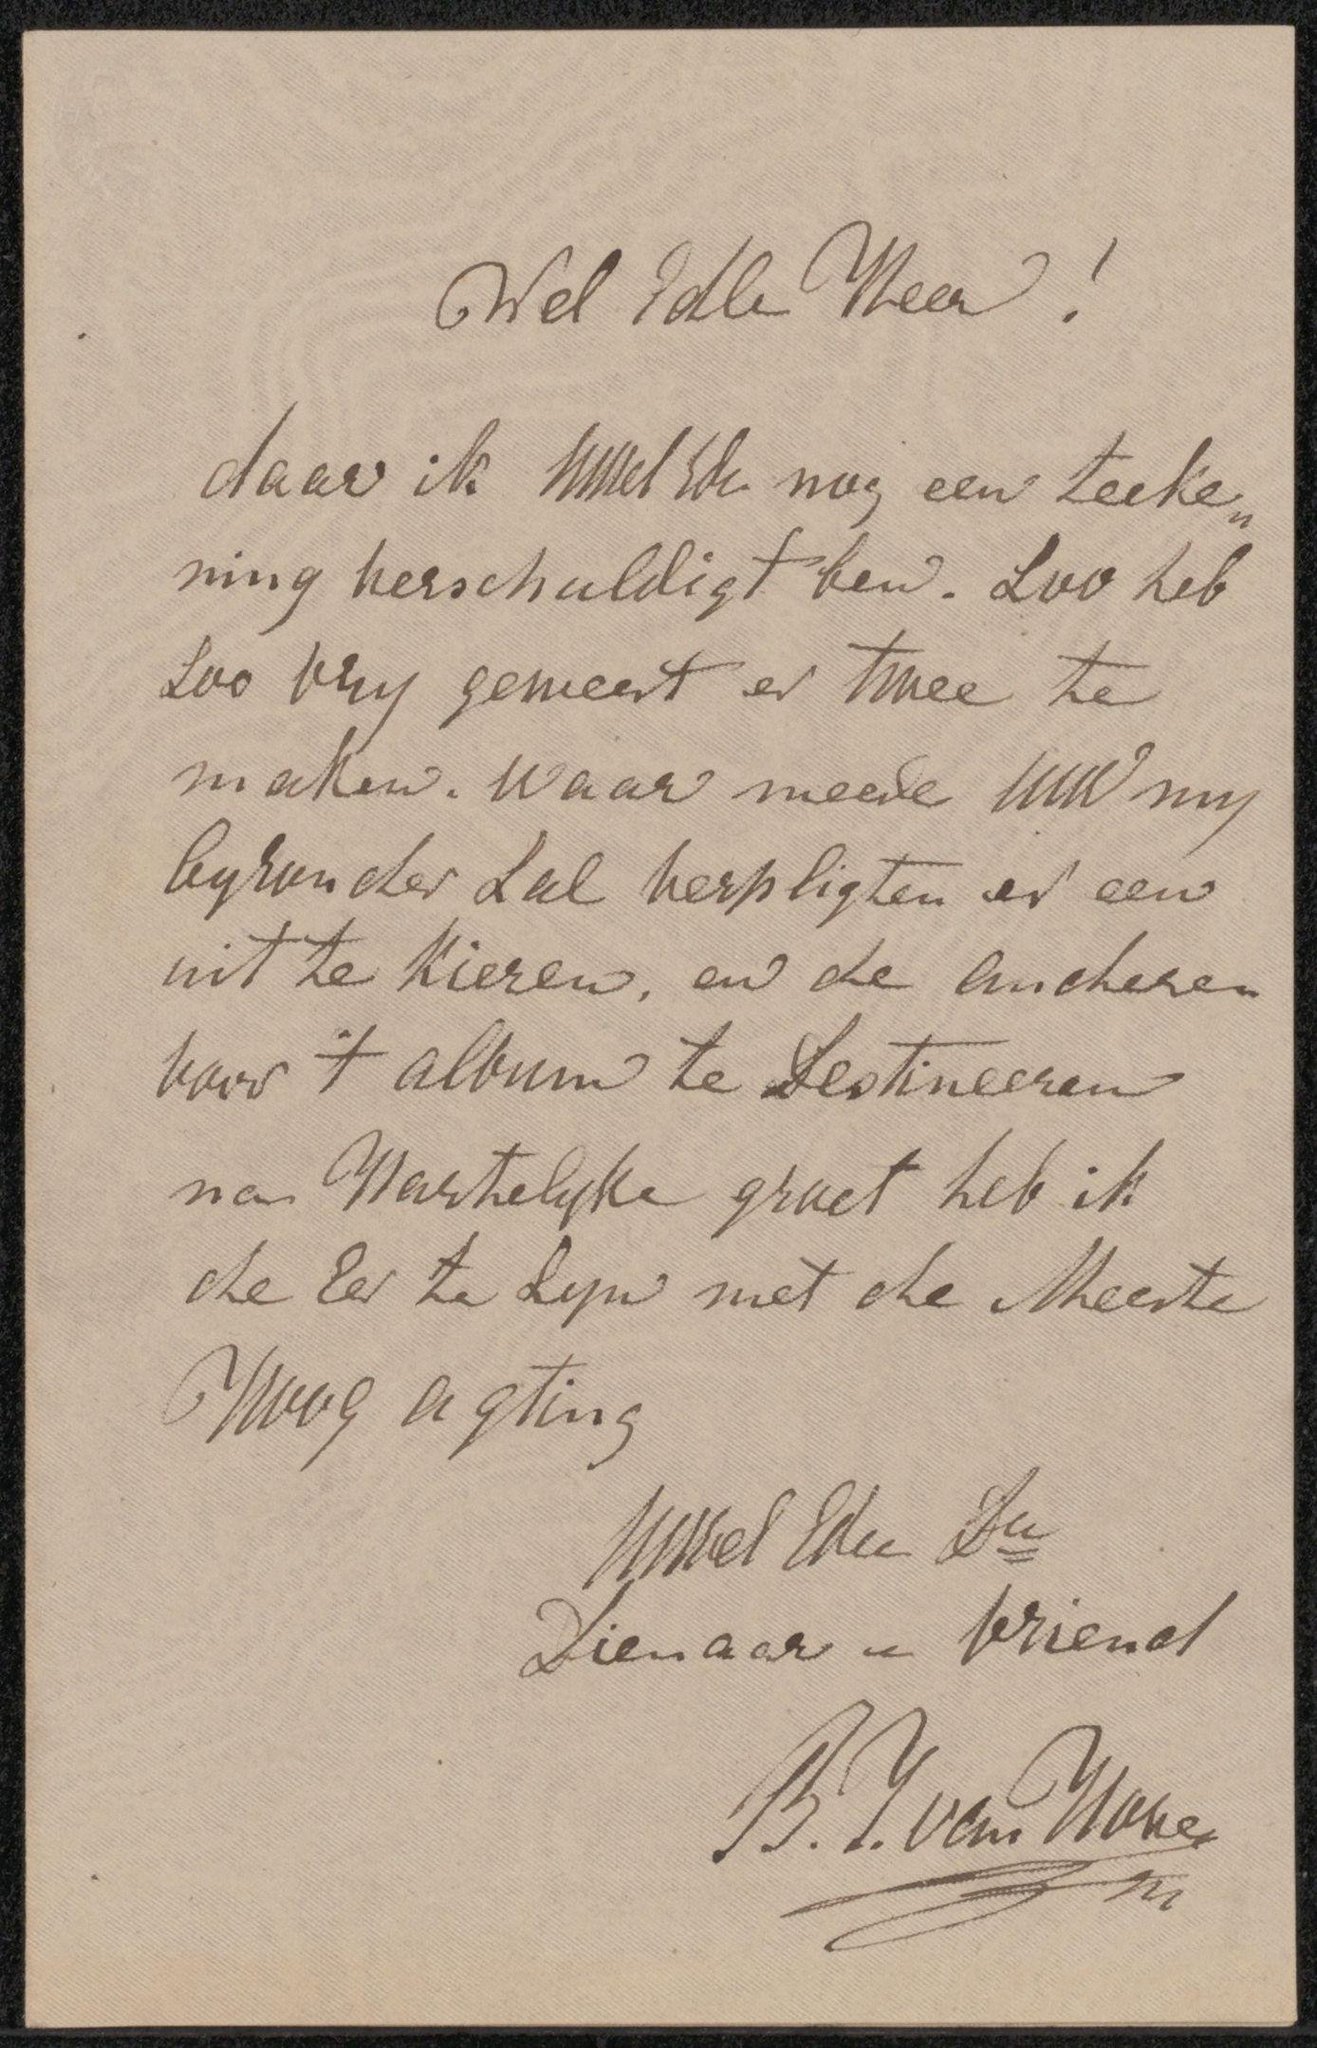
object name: letter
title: Brief aan anoniem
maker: bartholomeus johannes van hove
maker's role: draughtsman, painter, print maker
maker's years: 1790-1880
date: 1800-1880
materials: ink, paper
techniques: pen, writing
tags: drawing